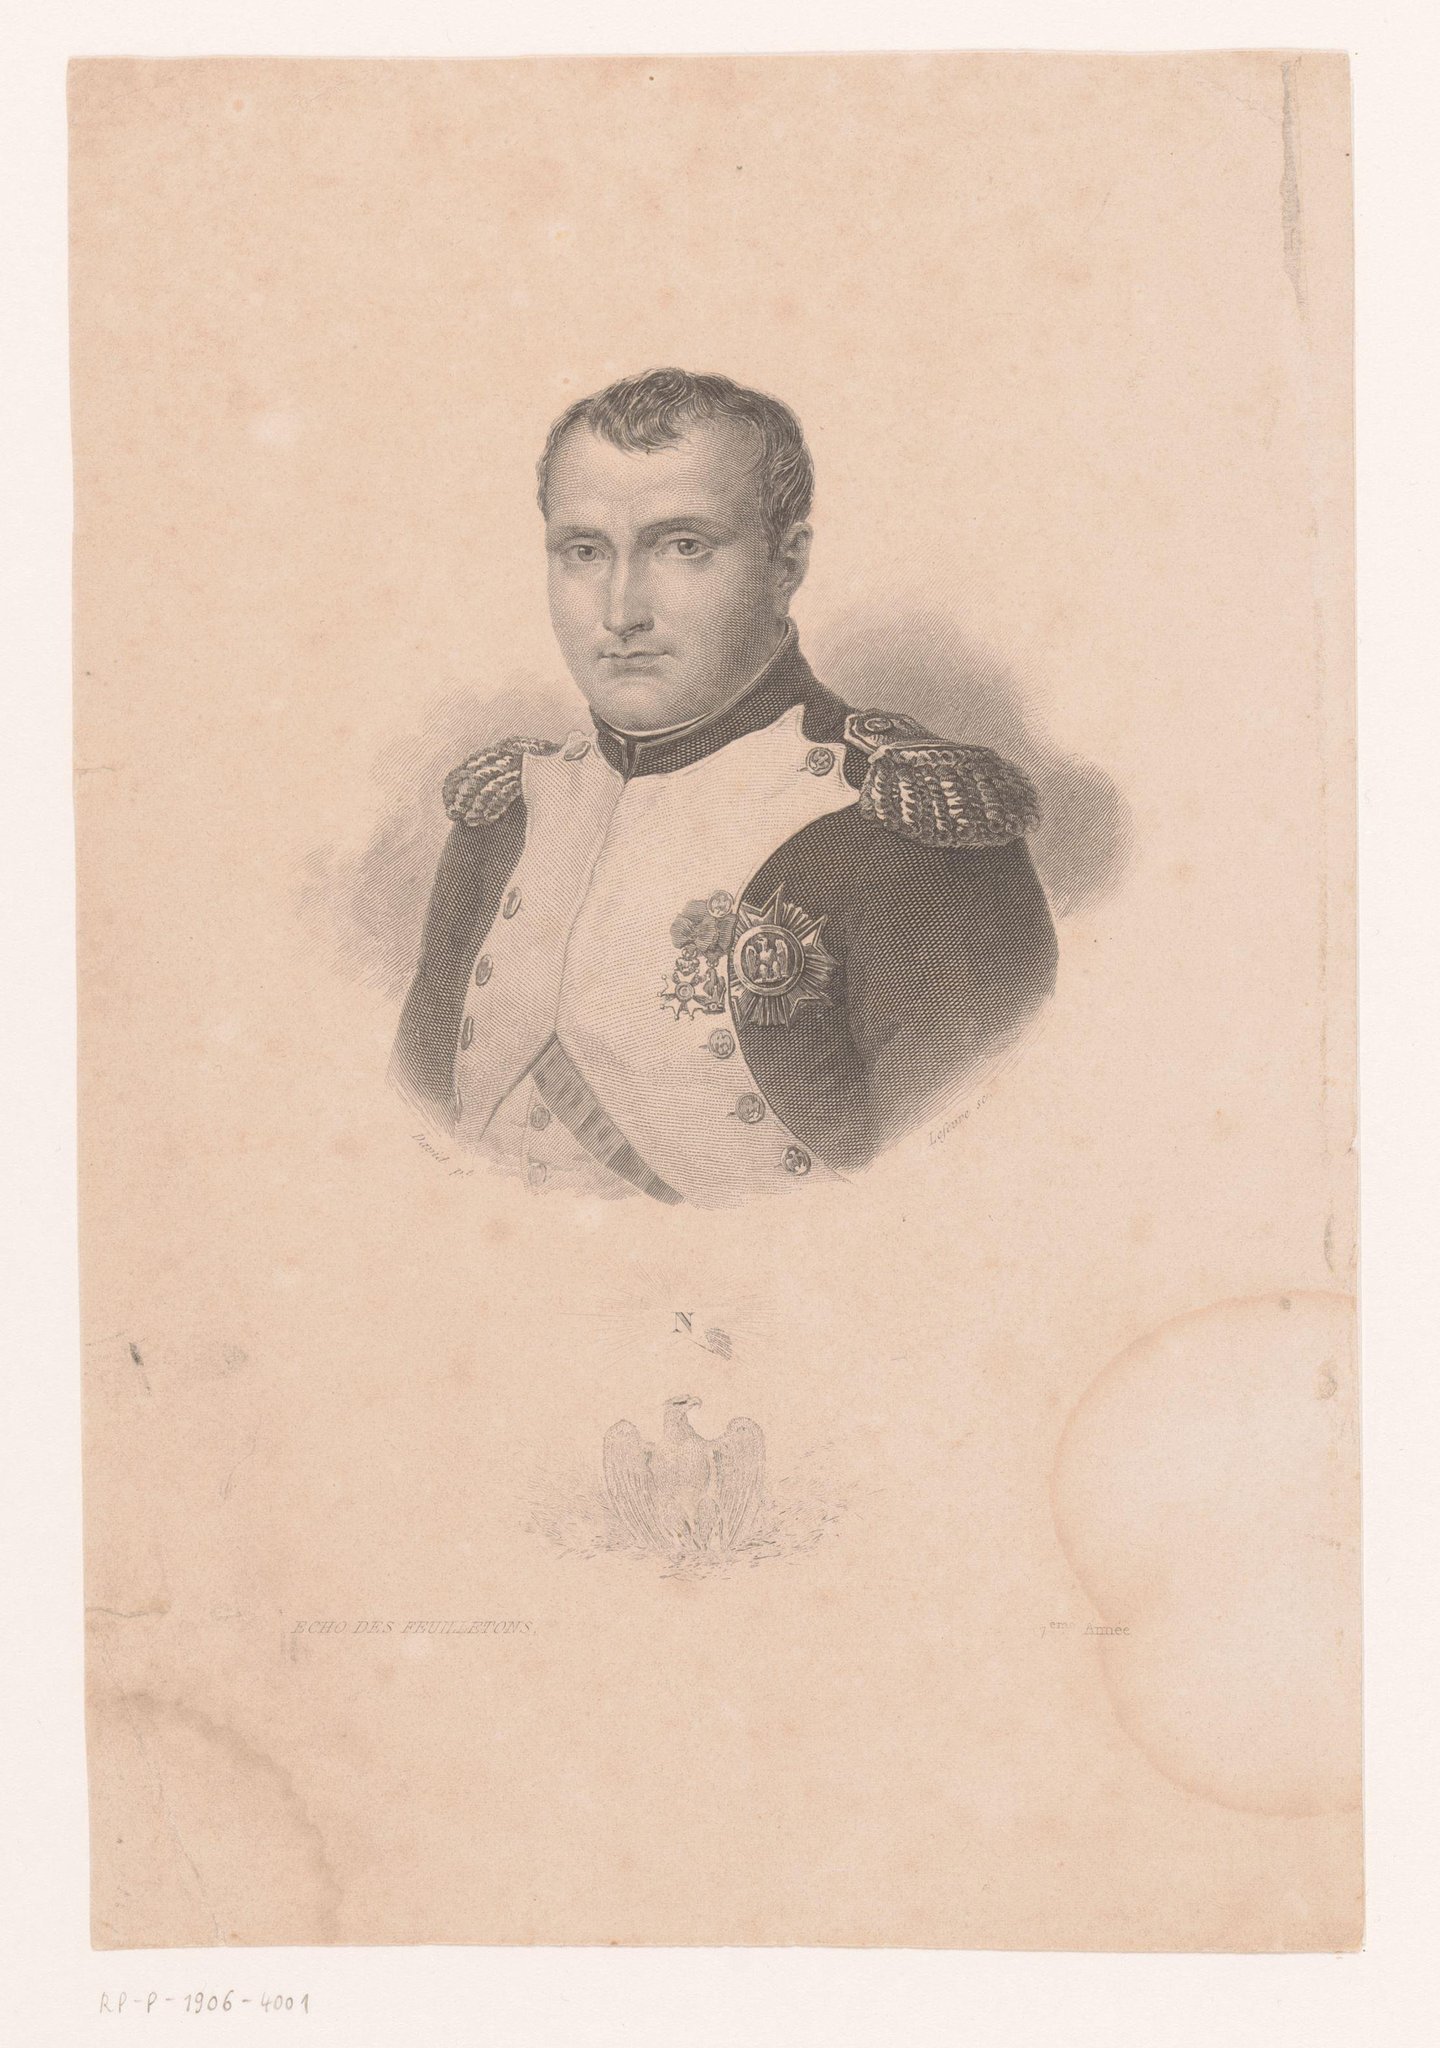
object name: print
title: Portret van Napoleon Bonaparte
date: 1808-1864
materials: paper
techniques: engraving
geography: france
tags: napoleon i (emperor of the french), predatory birds: eagle, historical persons, ruler, sovereign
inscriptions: collector's mark: Lugt 2228